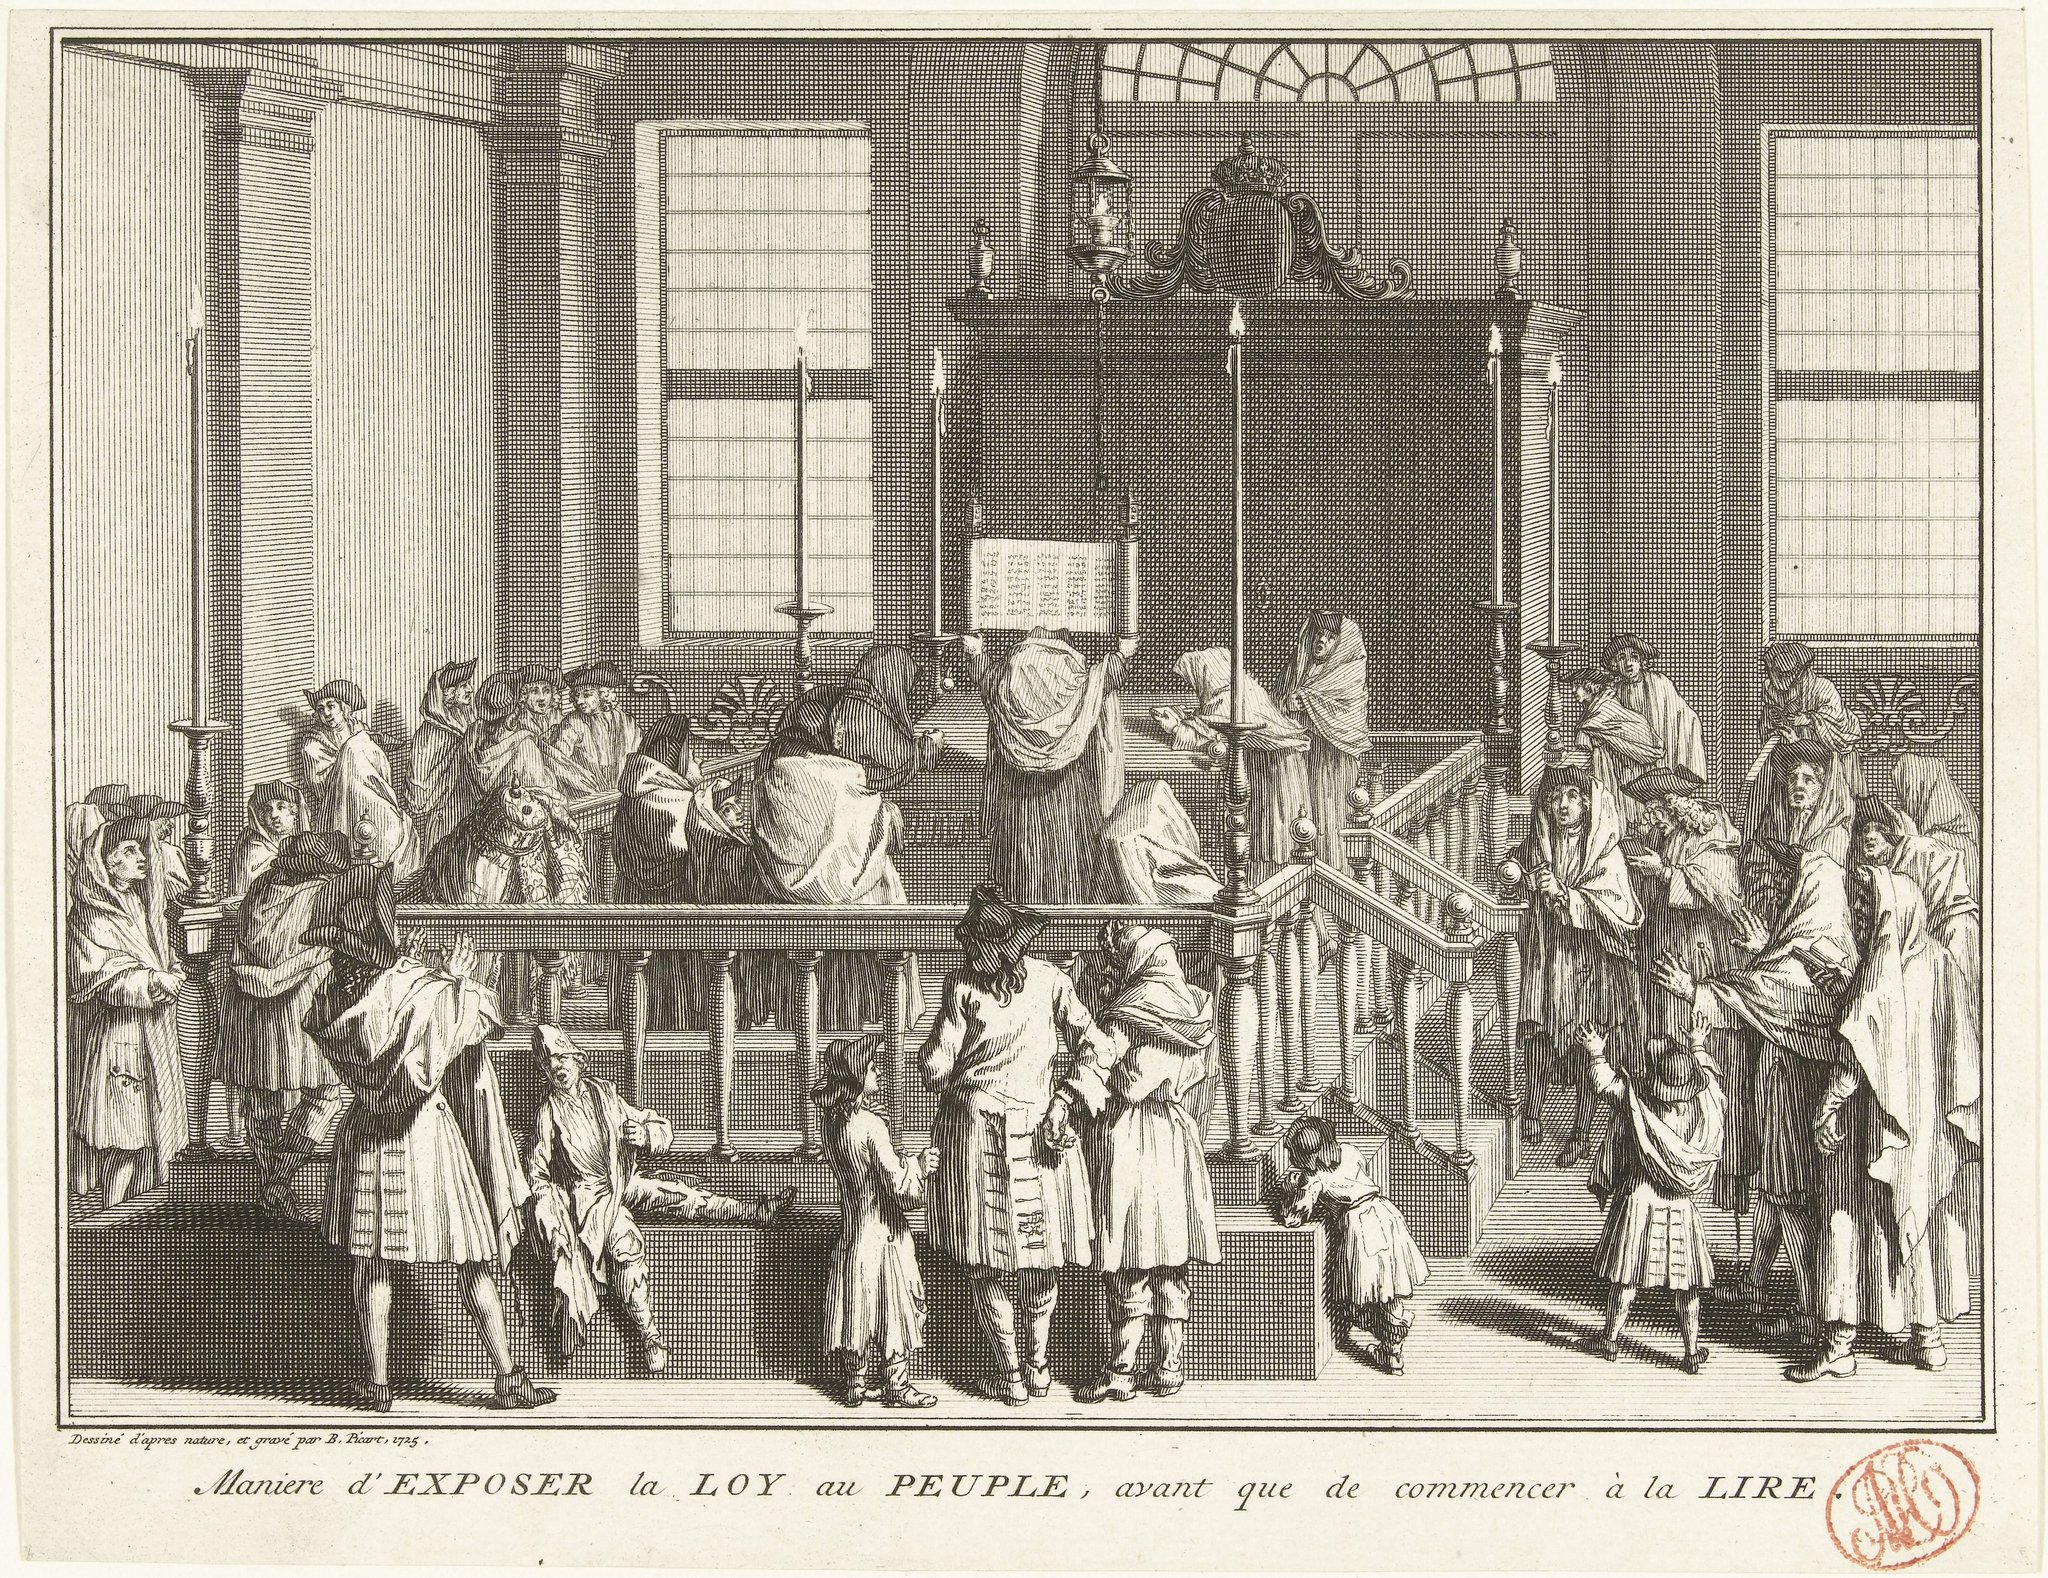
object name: print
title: Maniere d'Exposer la Loy au Peuple, avant que de commencer à la Lire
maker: bernard picart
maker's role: draughtsman, print maker, publisher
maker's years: 1673-1733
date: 1725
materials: paper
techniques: engraving, etching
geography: northern netherlands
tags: reading of the torah ~ jewish religion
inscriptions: collector's mark: Lugt 195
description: Gebruikt als illustratie in: A. Moubach, Naaukeurige beschryving der uitwendige godtsdienst-plichten, kerk-zeden en gewoontens van alle volkeren der waereldt : in een historisch verhaal ... in kunstige tafereelen afgemaalt. 's-Gravenhage: R.C. Alberts, 6 dln, 1727-1738. Niet in Frederik Muller; door het RPK toegevoegd nummer.